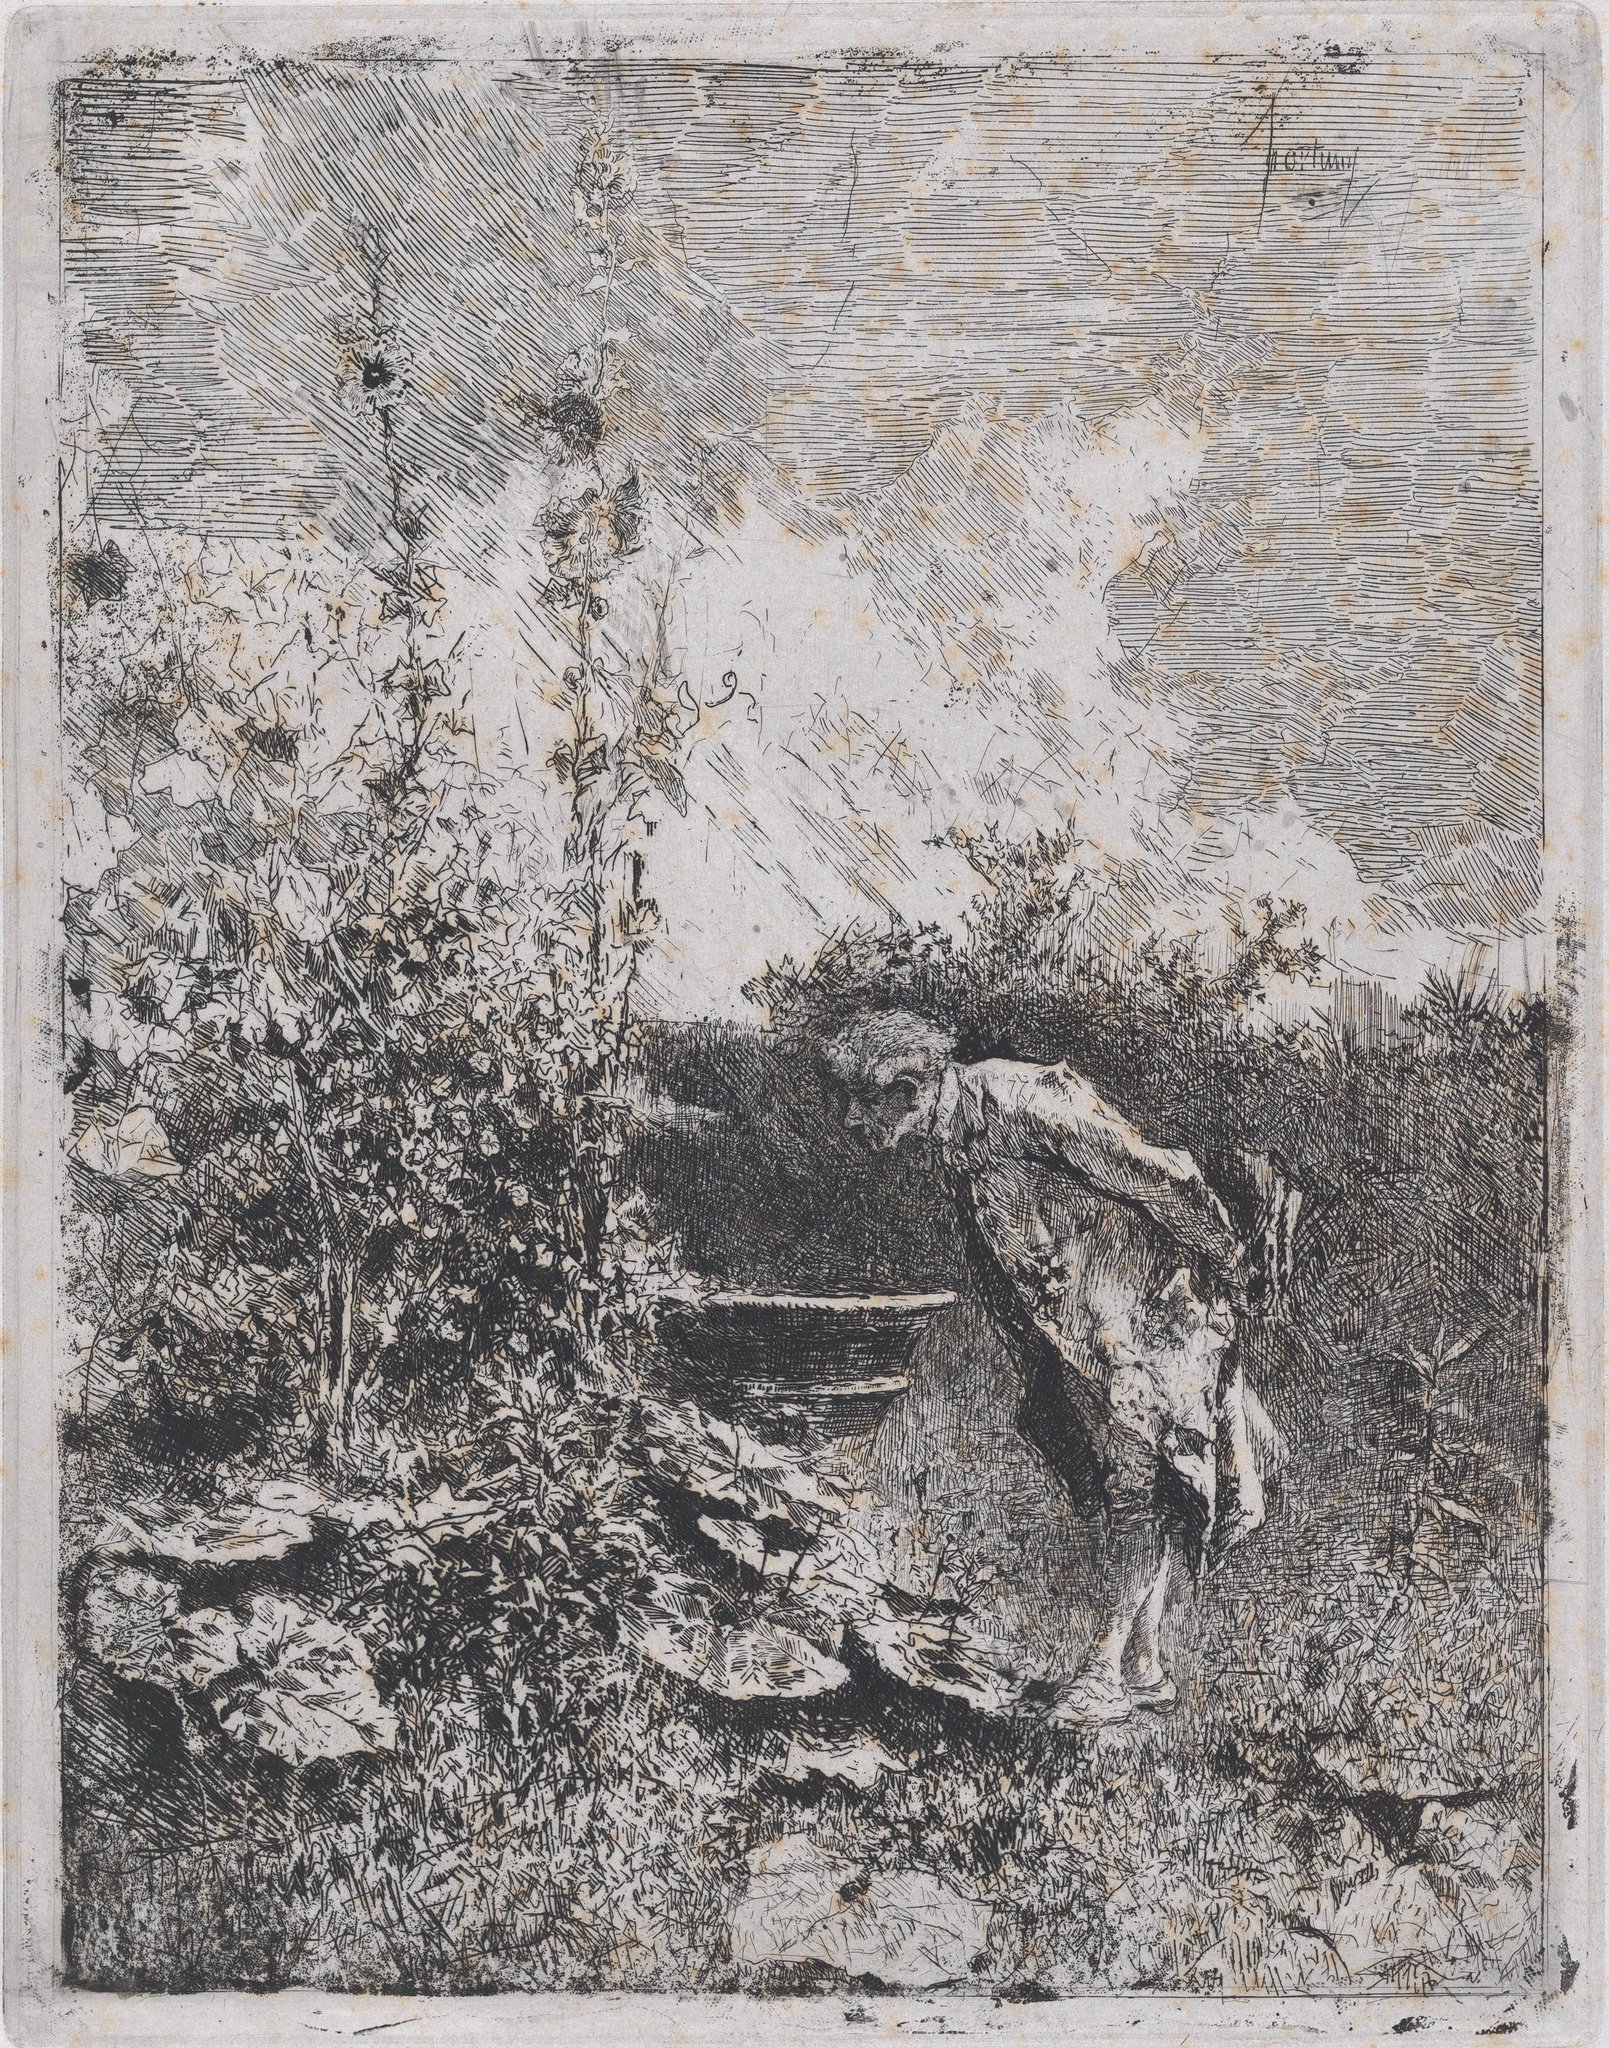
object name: print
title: The botanist: a man in a garden examining its contents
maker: mariano fortuny, 1838–1874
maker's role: artist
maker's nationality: spanish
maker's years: 1838-1874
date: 1860-1870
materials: paper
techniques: etching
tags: gardens,men